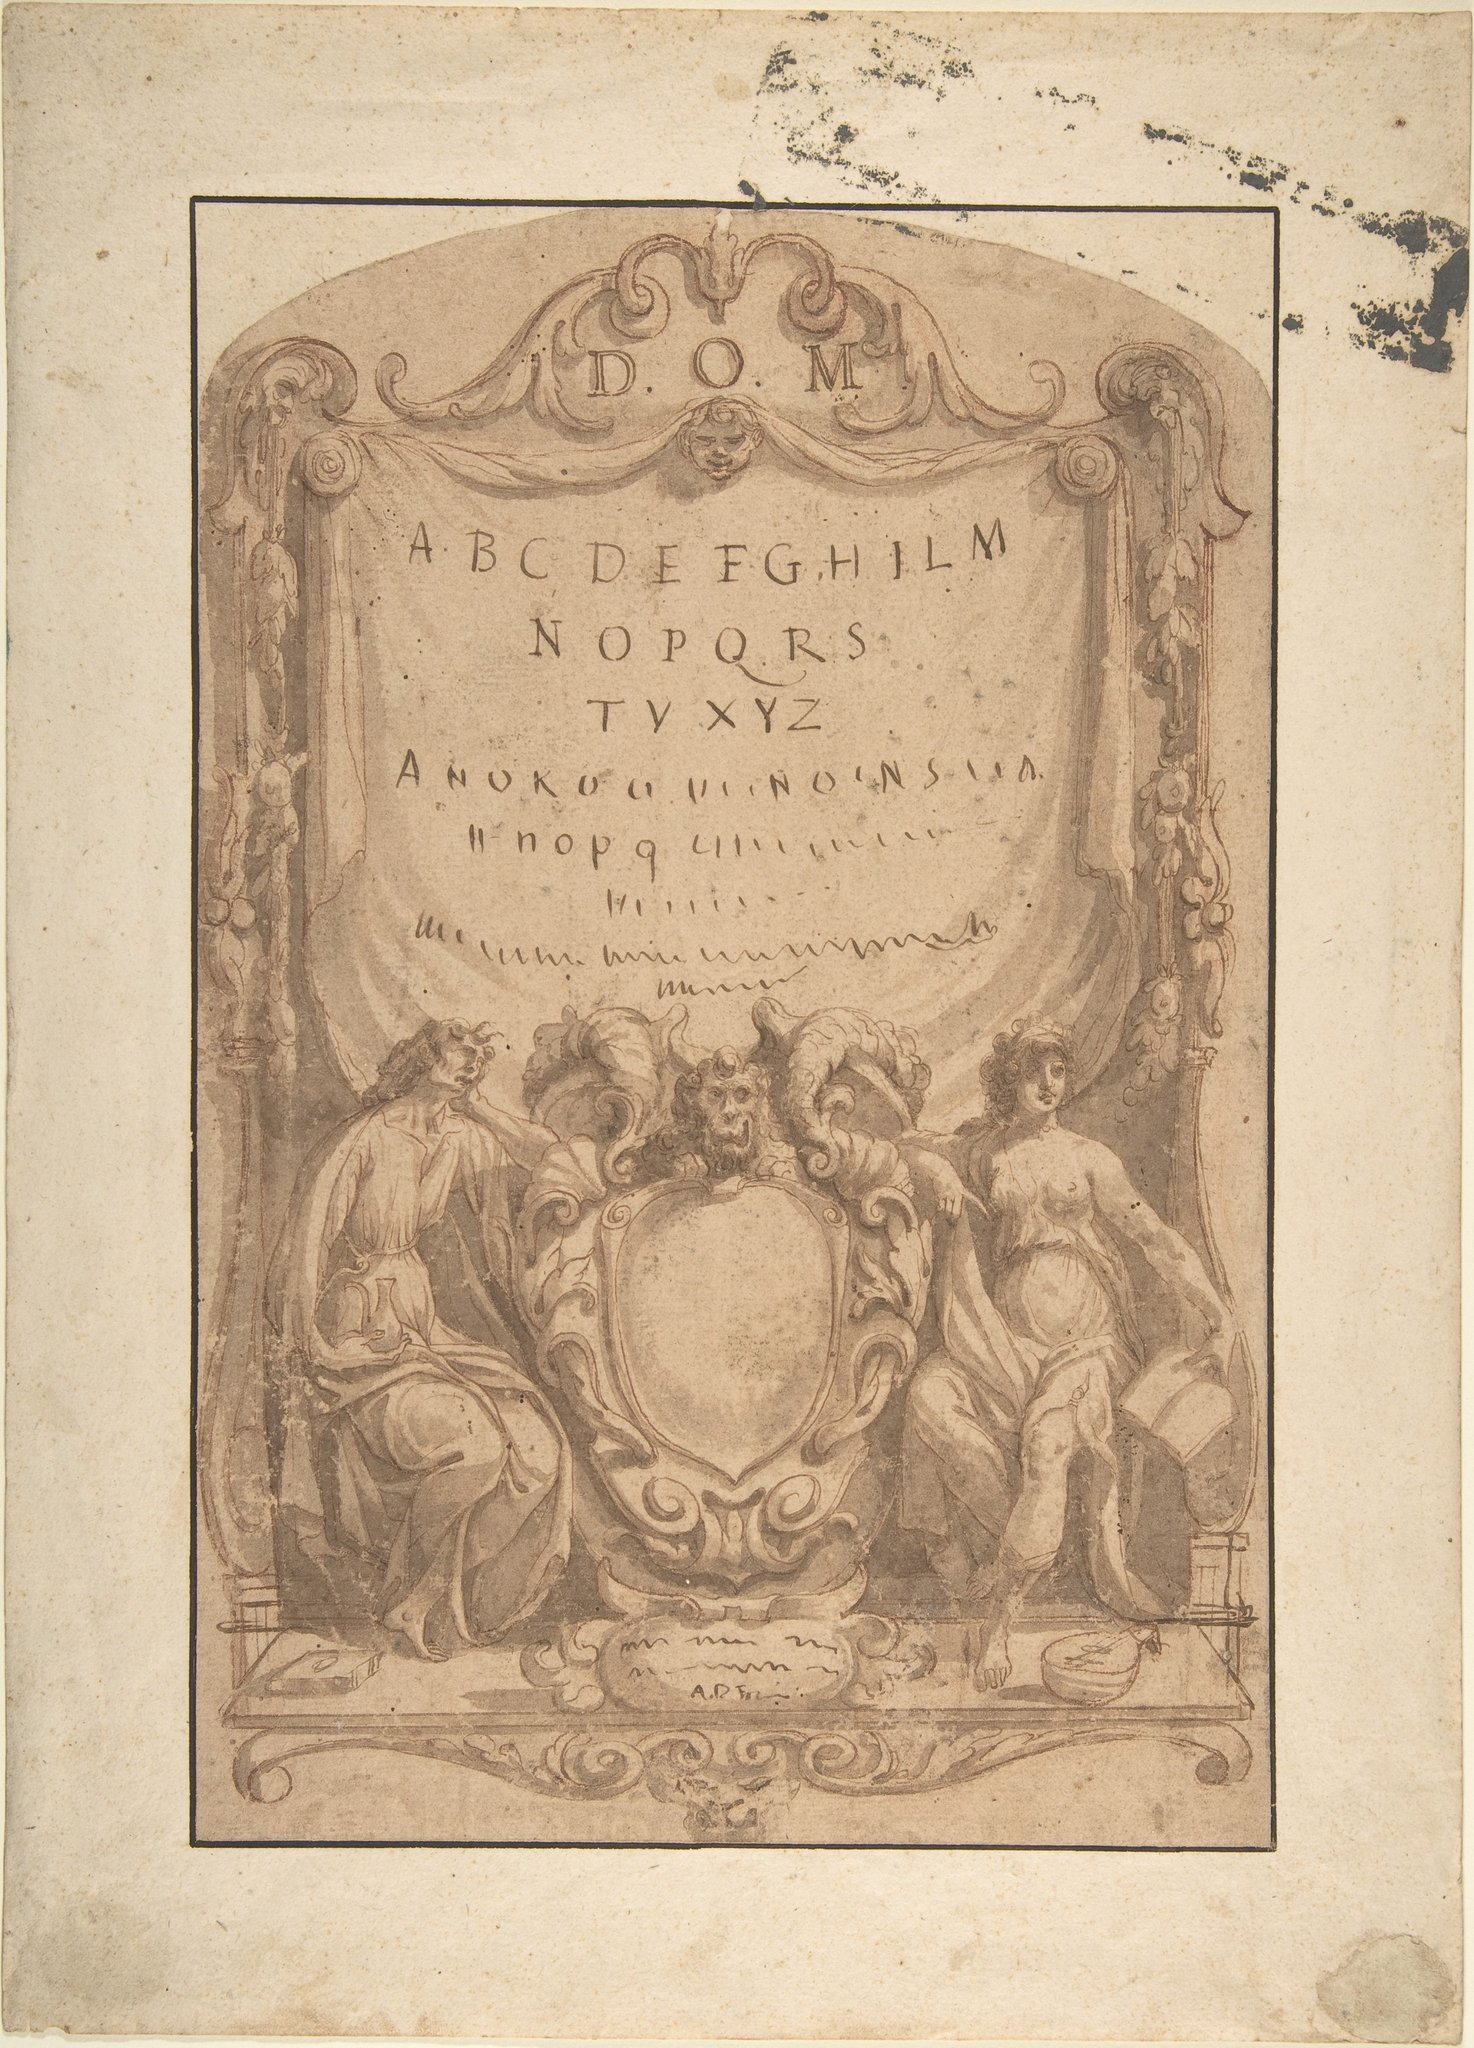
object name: drawing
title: Design for a Title Page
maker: anonymous, german, 18th century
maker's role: artist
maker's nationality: german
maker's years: 1700-1800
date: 1701-1800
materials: ink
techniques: brush, incising, pen, transfer, wash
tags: women,coat of arms